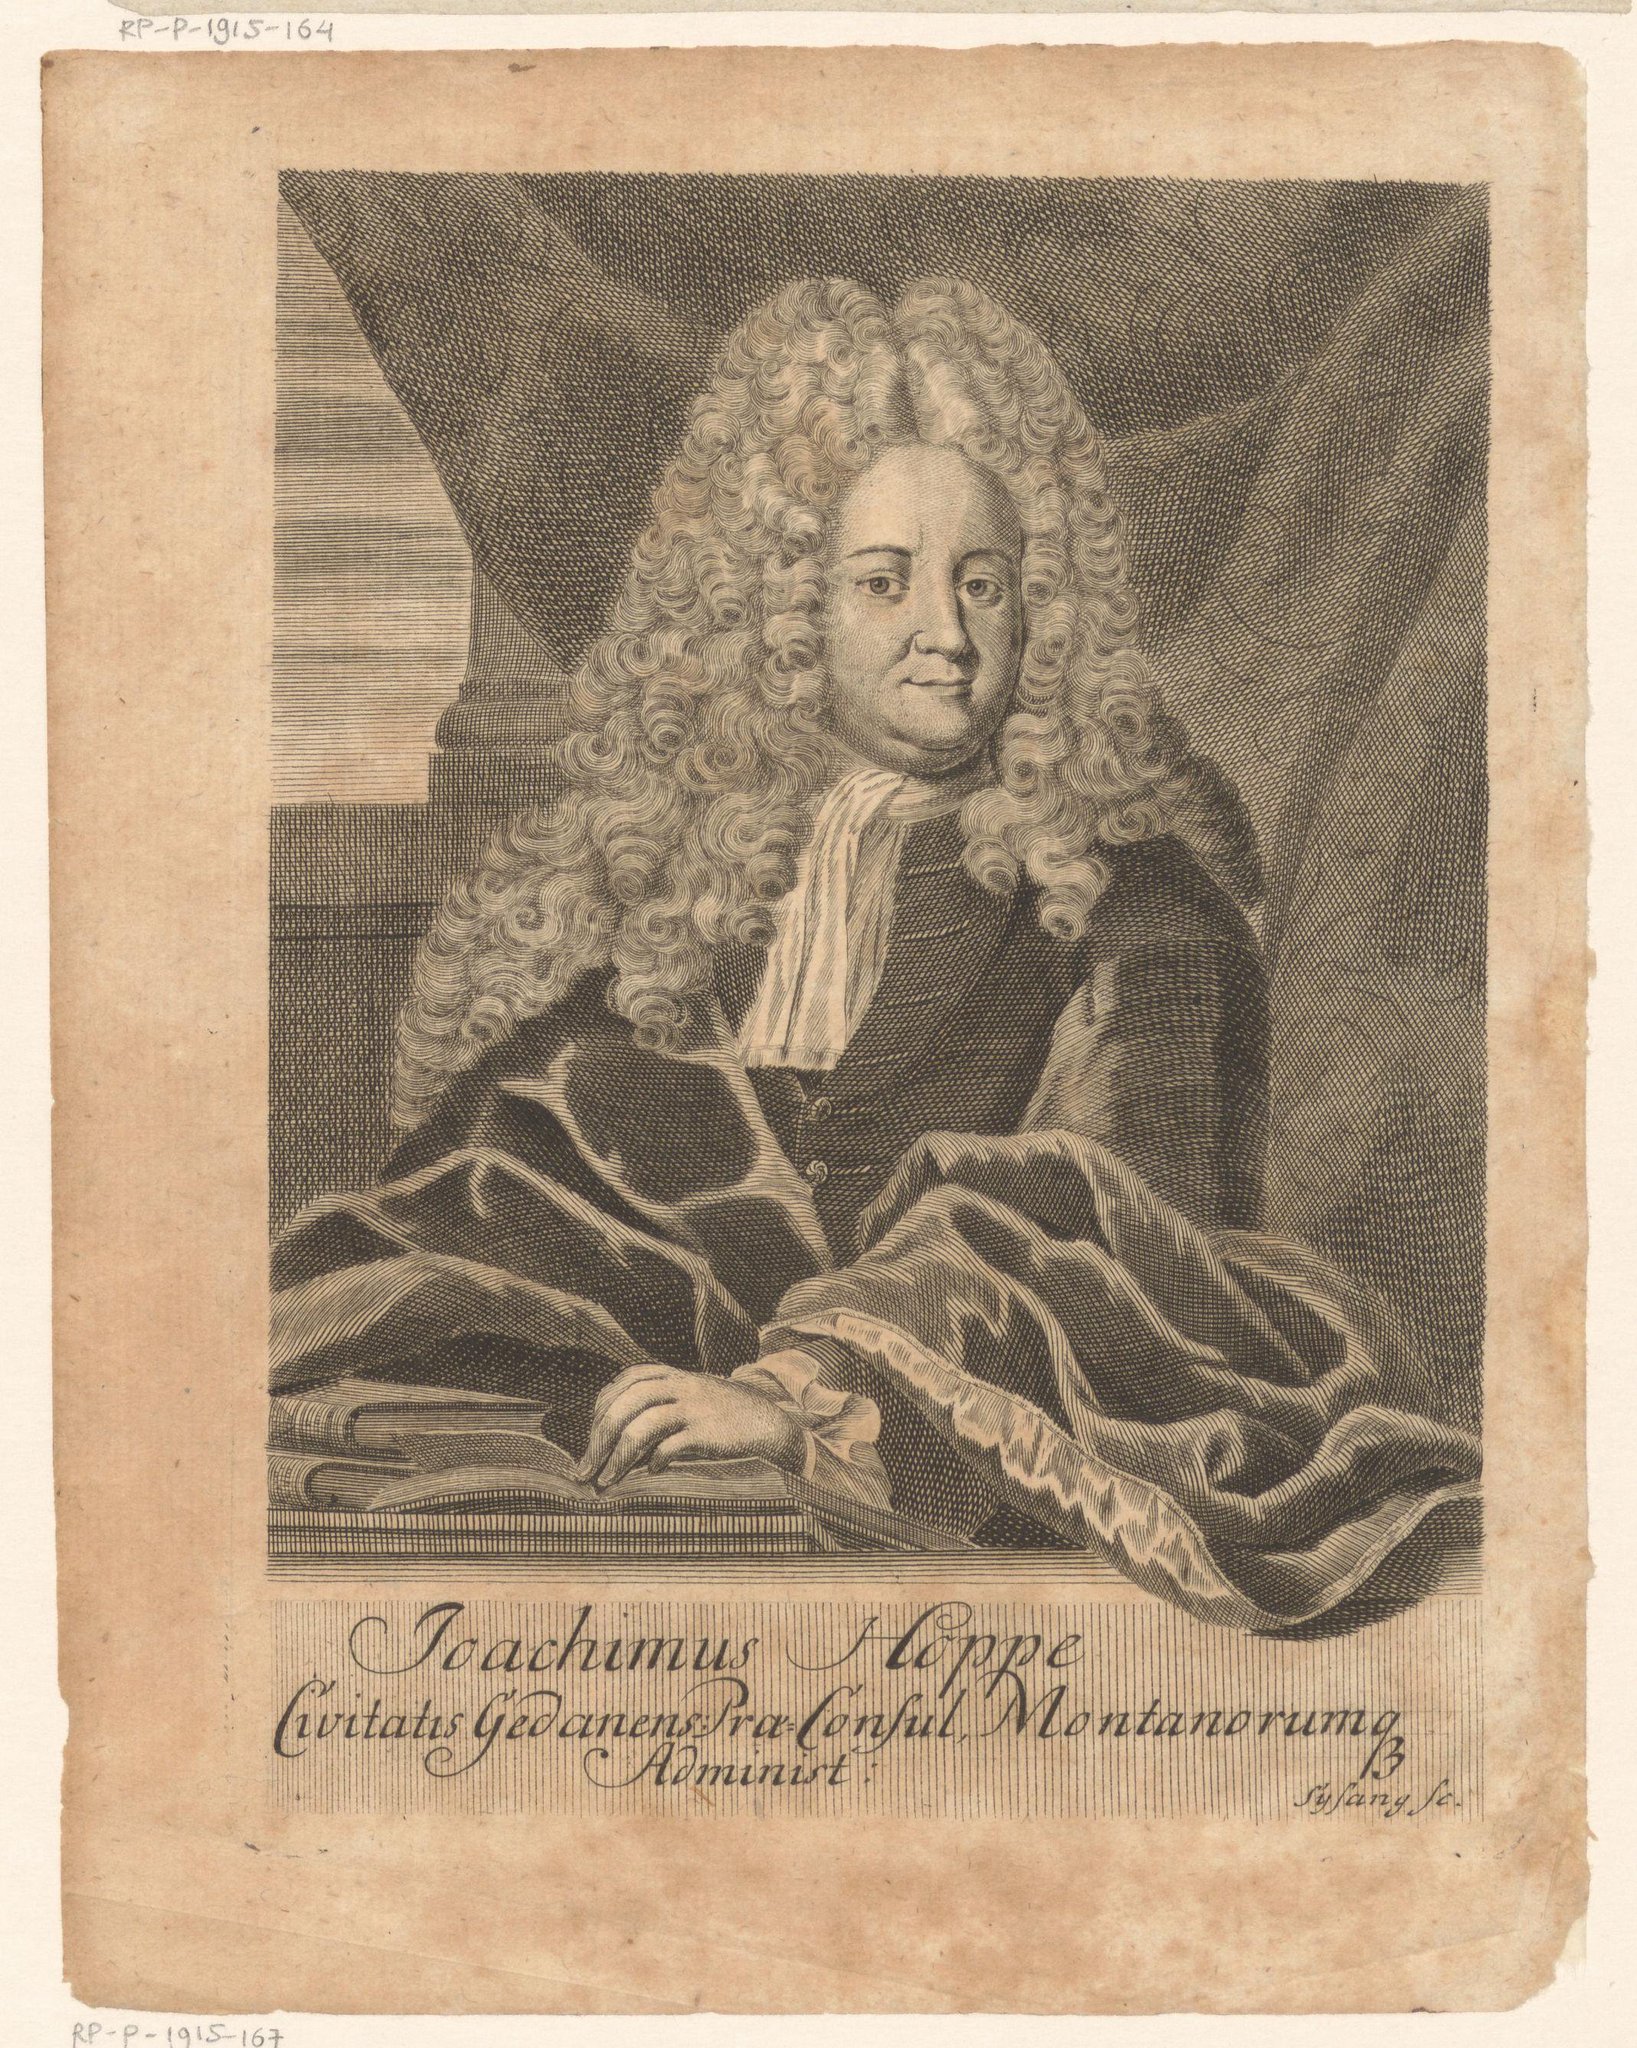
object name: print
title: Portret van Joachim Hoppe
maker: johann christoph sysang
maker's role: print maker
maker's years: 1703-1757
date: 1713-1757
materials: paper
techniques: engraving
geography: germany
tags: mayor, historical persons, book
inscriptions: collector's mark: Lugt 2228